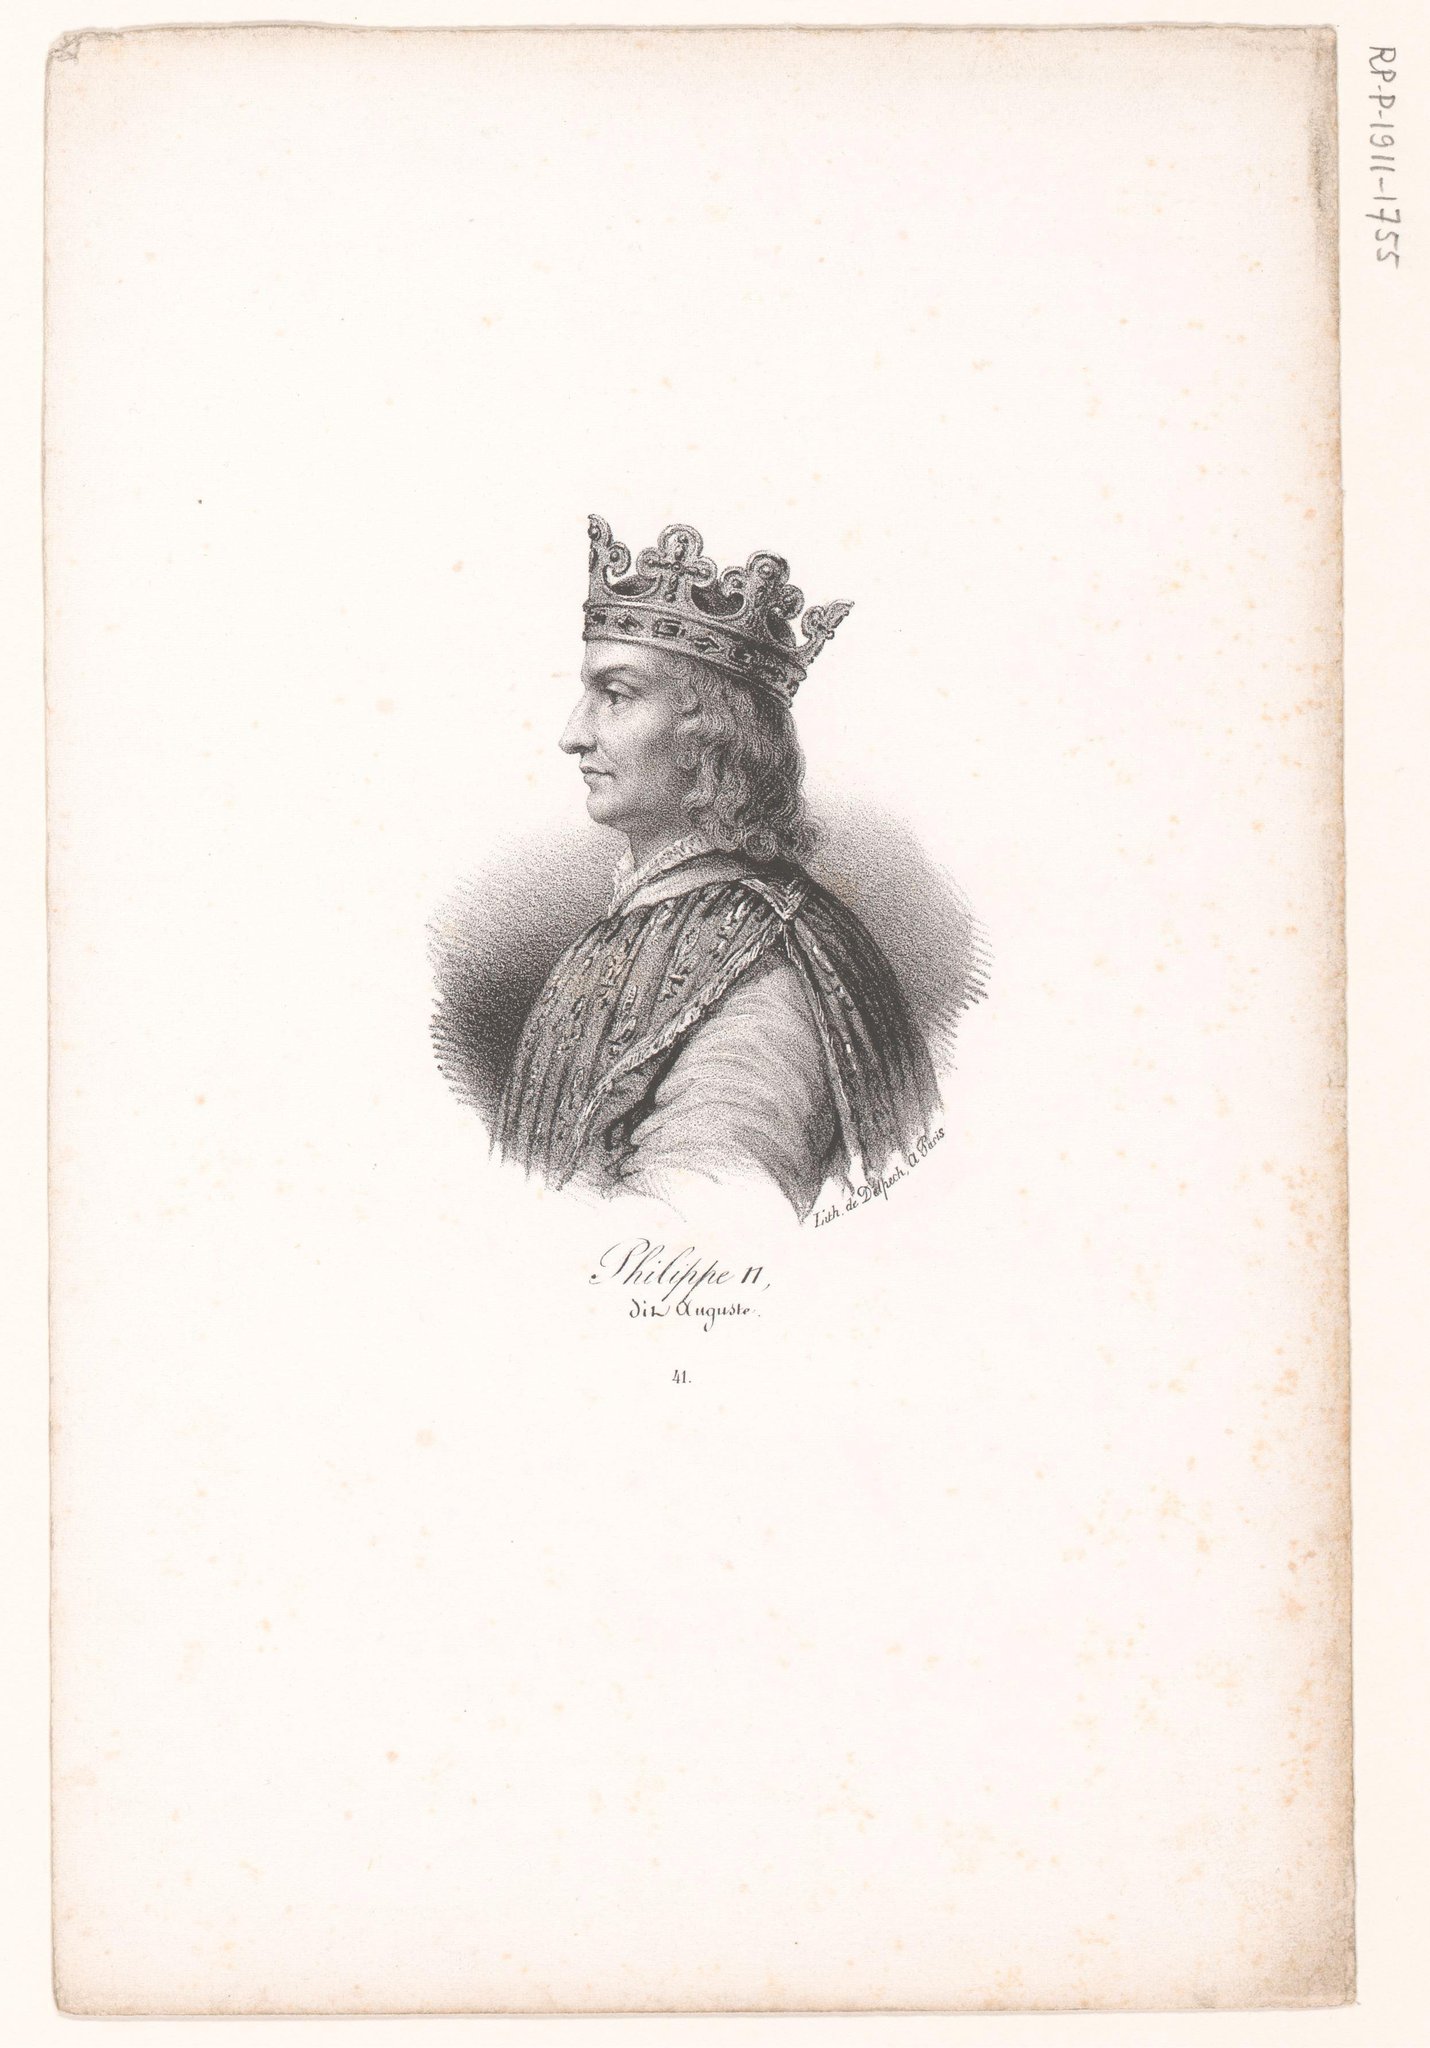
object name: print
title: Portret van Filips II van Frankrijk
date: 1818-1842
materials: paper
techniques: lithograph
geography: paris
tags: paris, historical persons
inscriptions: collector's mark: Lugt 2228a